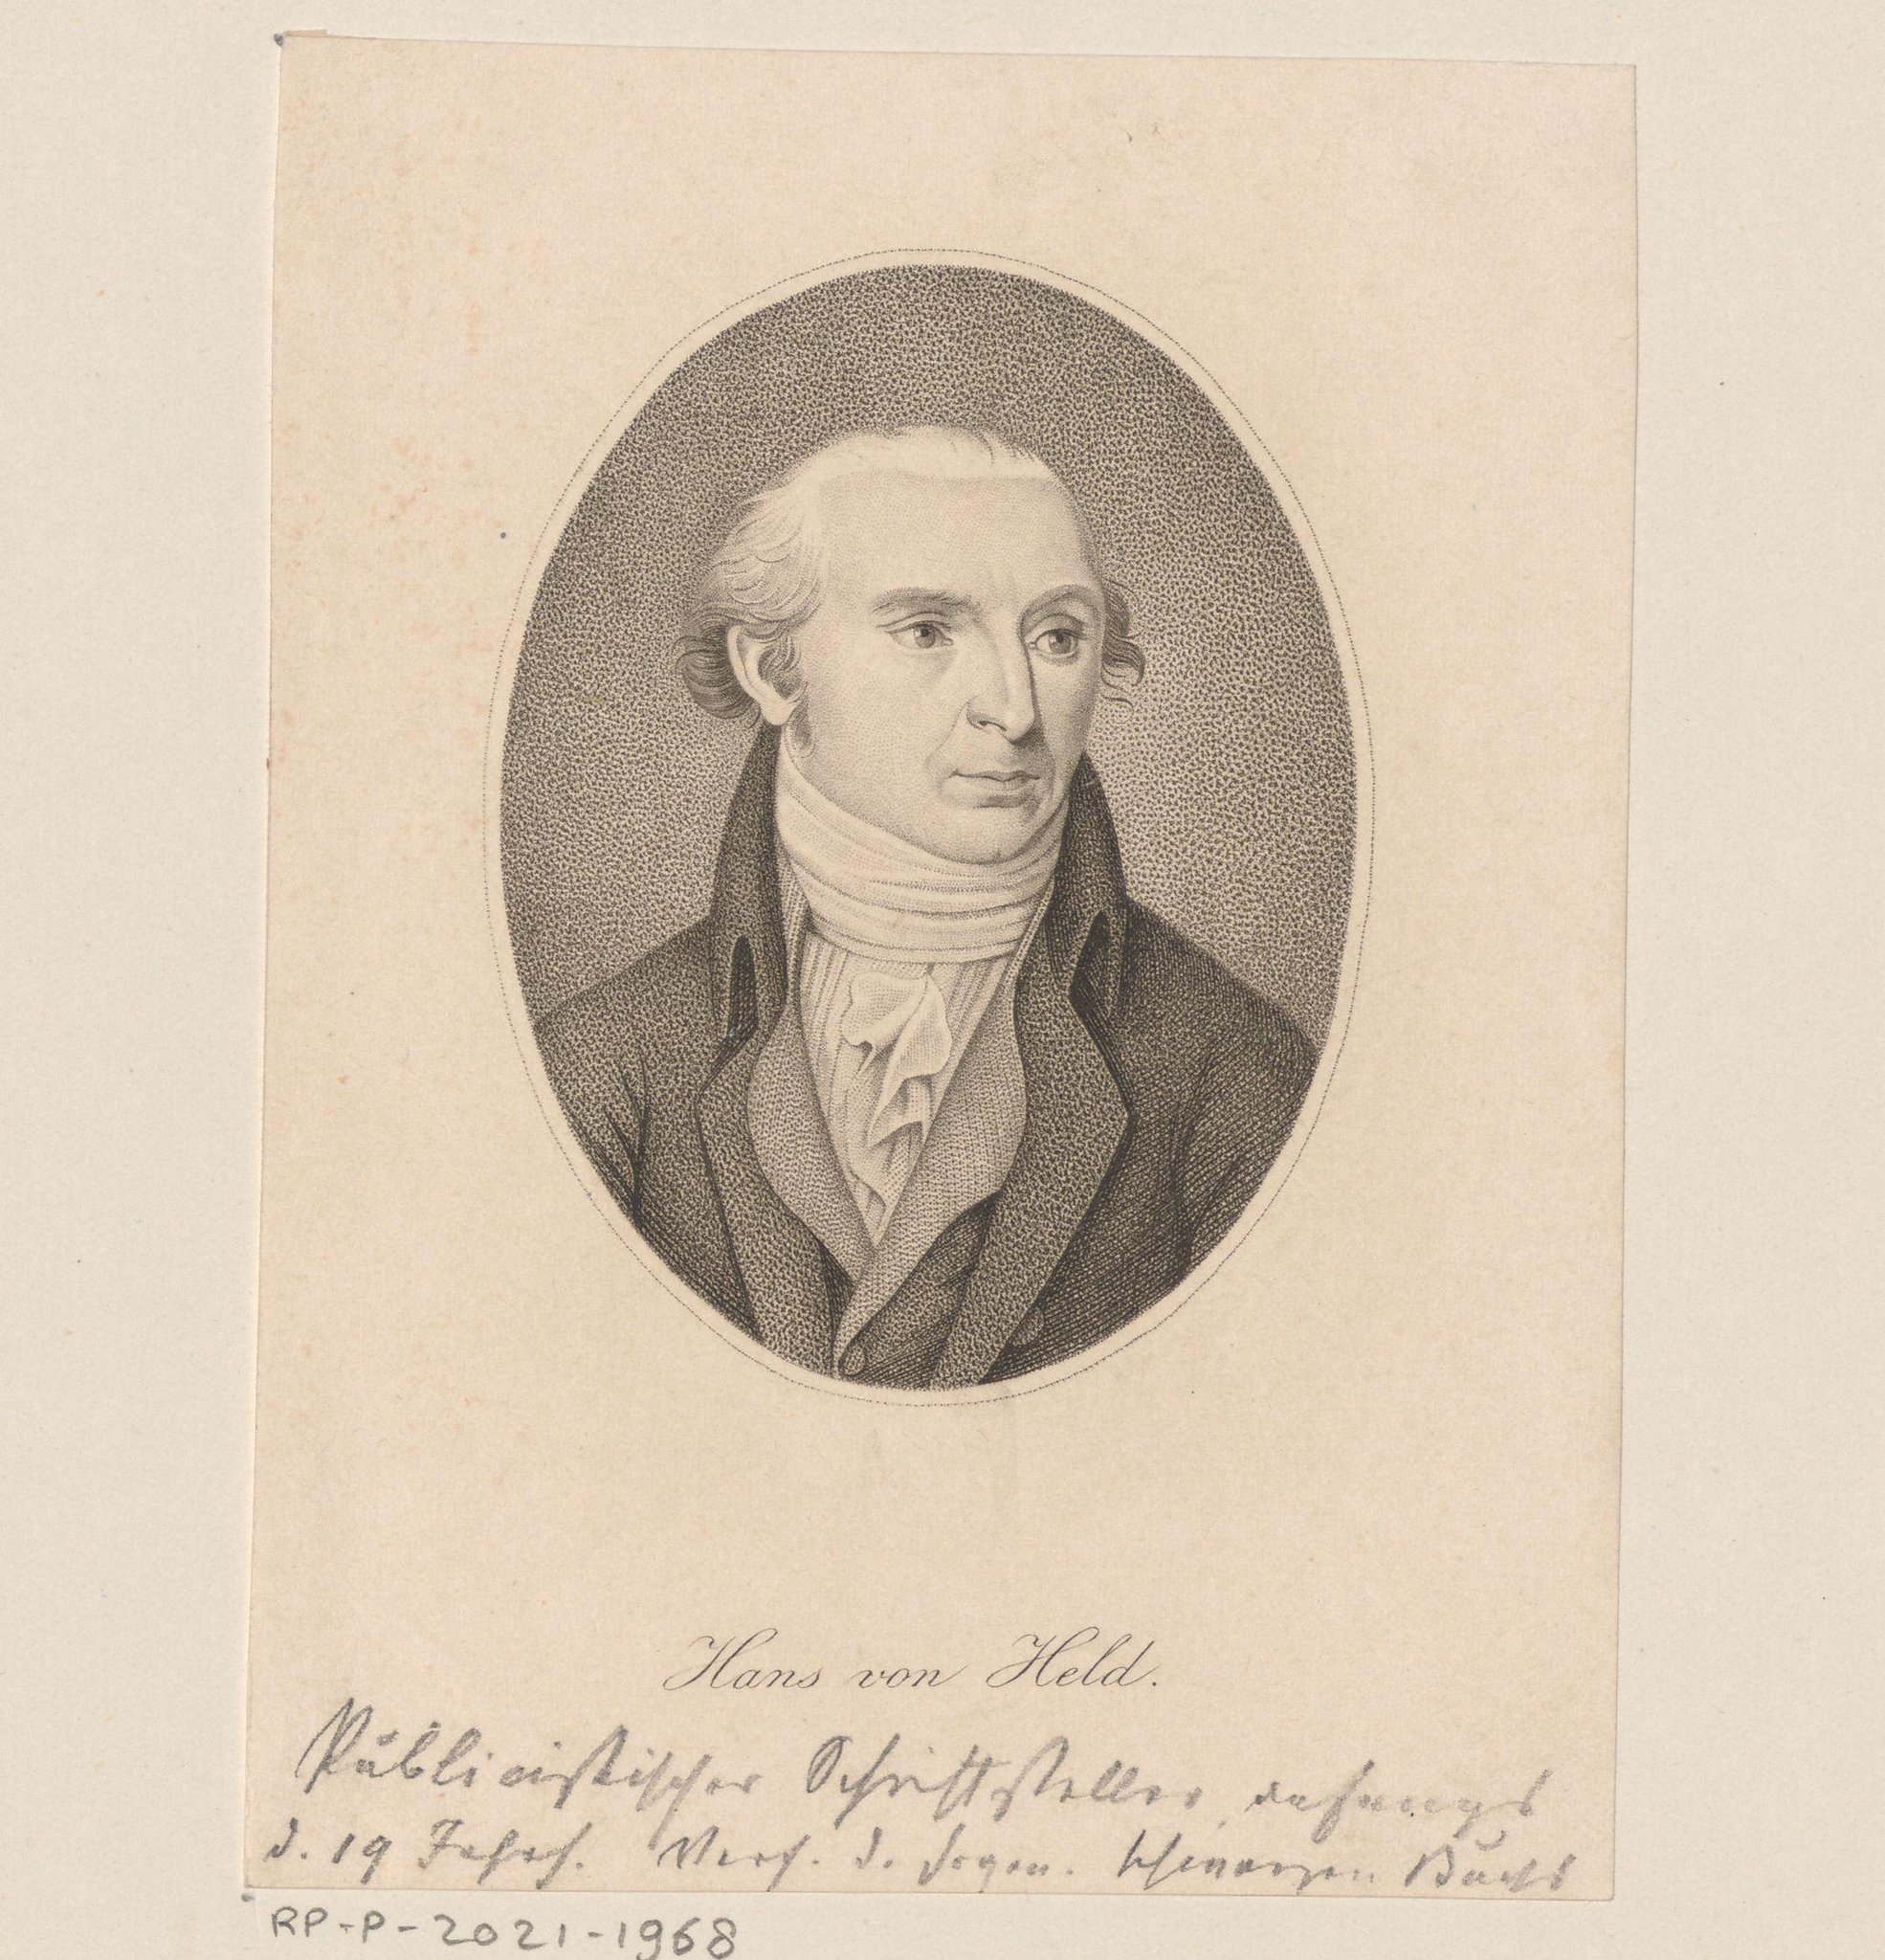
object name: print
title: Portret van Hans Heinrich Ludwig von Held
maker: Anonymous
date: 1800-1849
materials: paper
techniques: engraving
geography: germany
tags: berlin, historical persons, portrait of a writer